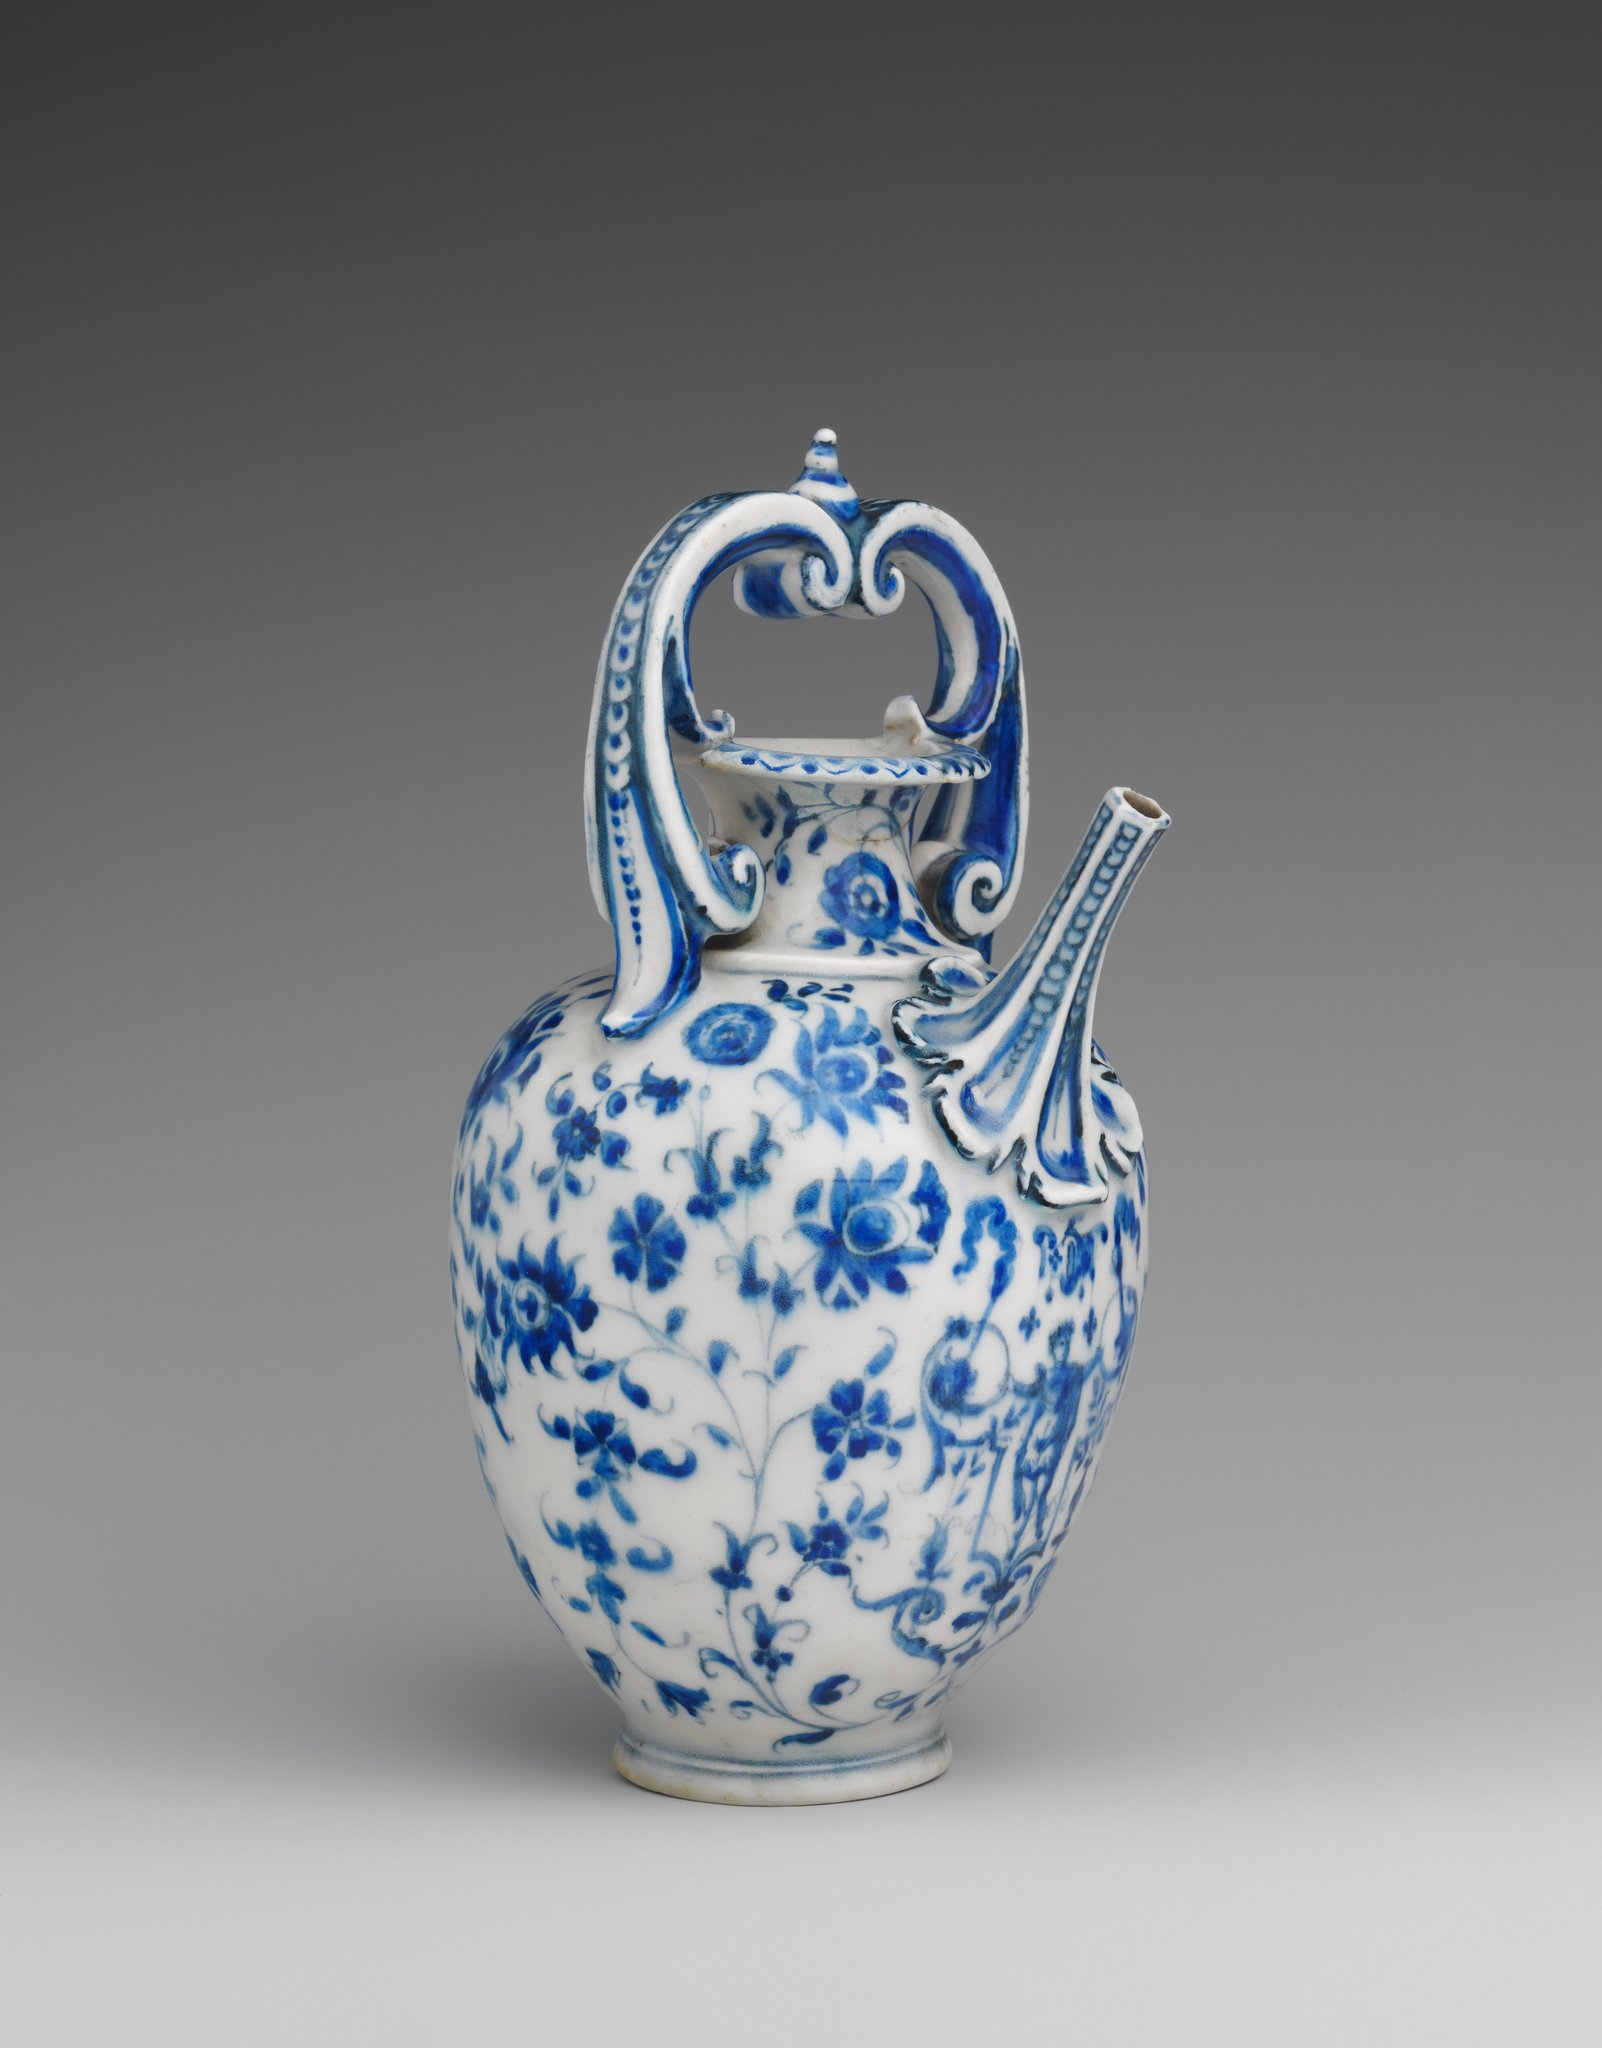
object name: ewer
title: Ewer (Brocca)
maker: medici porcelain manufactory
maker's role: manufactory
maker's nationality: italian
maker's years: 1570-1592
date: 1575-1587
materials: soft paste porcelain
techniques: underglaze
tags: men,flowers